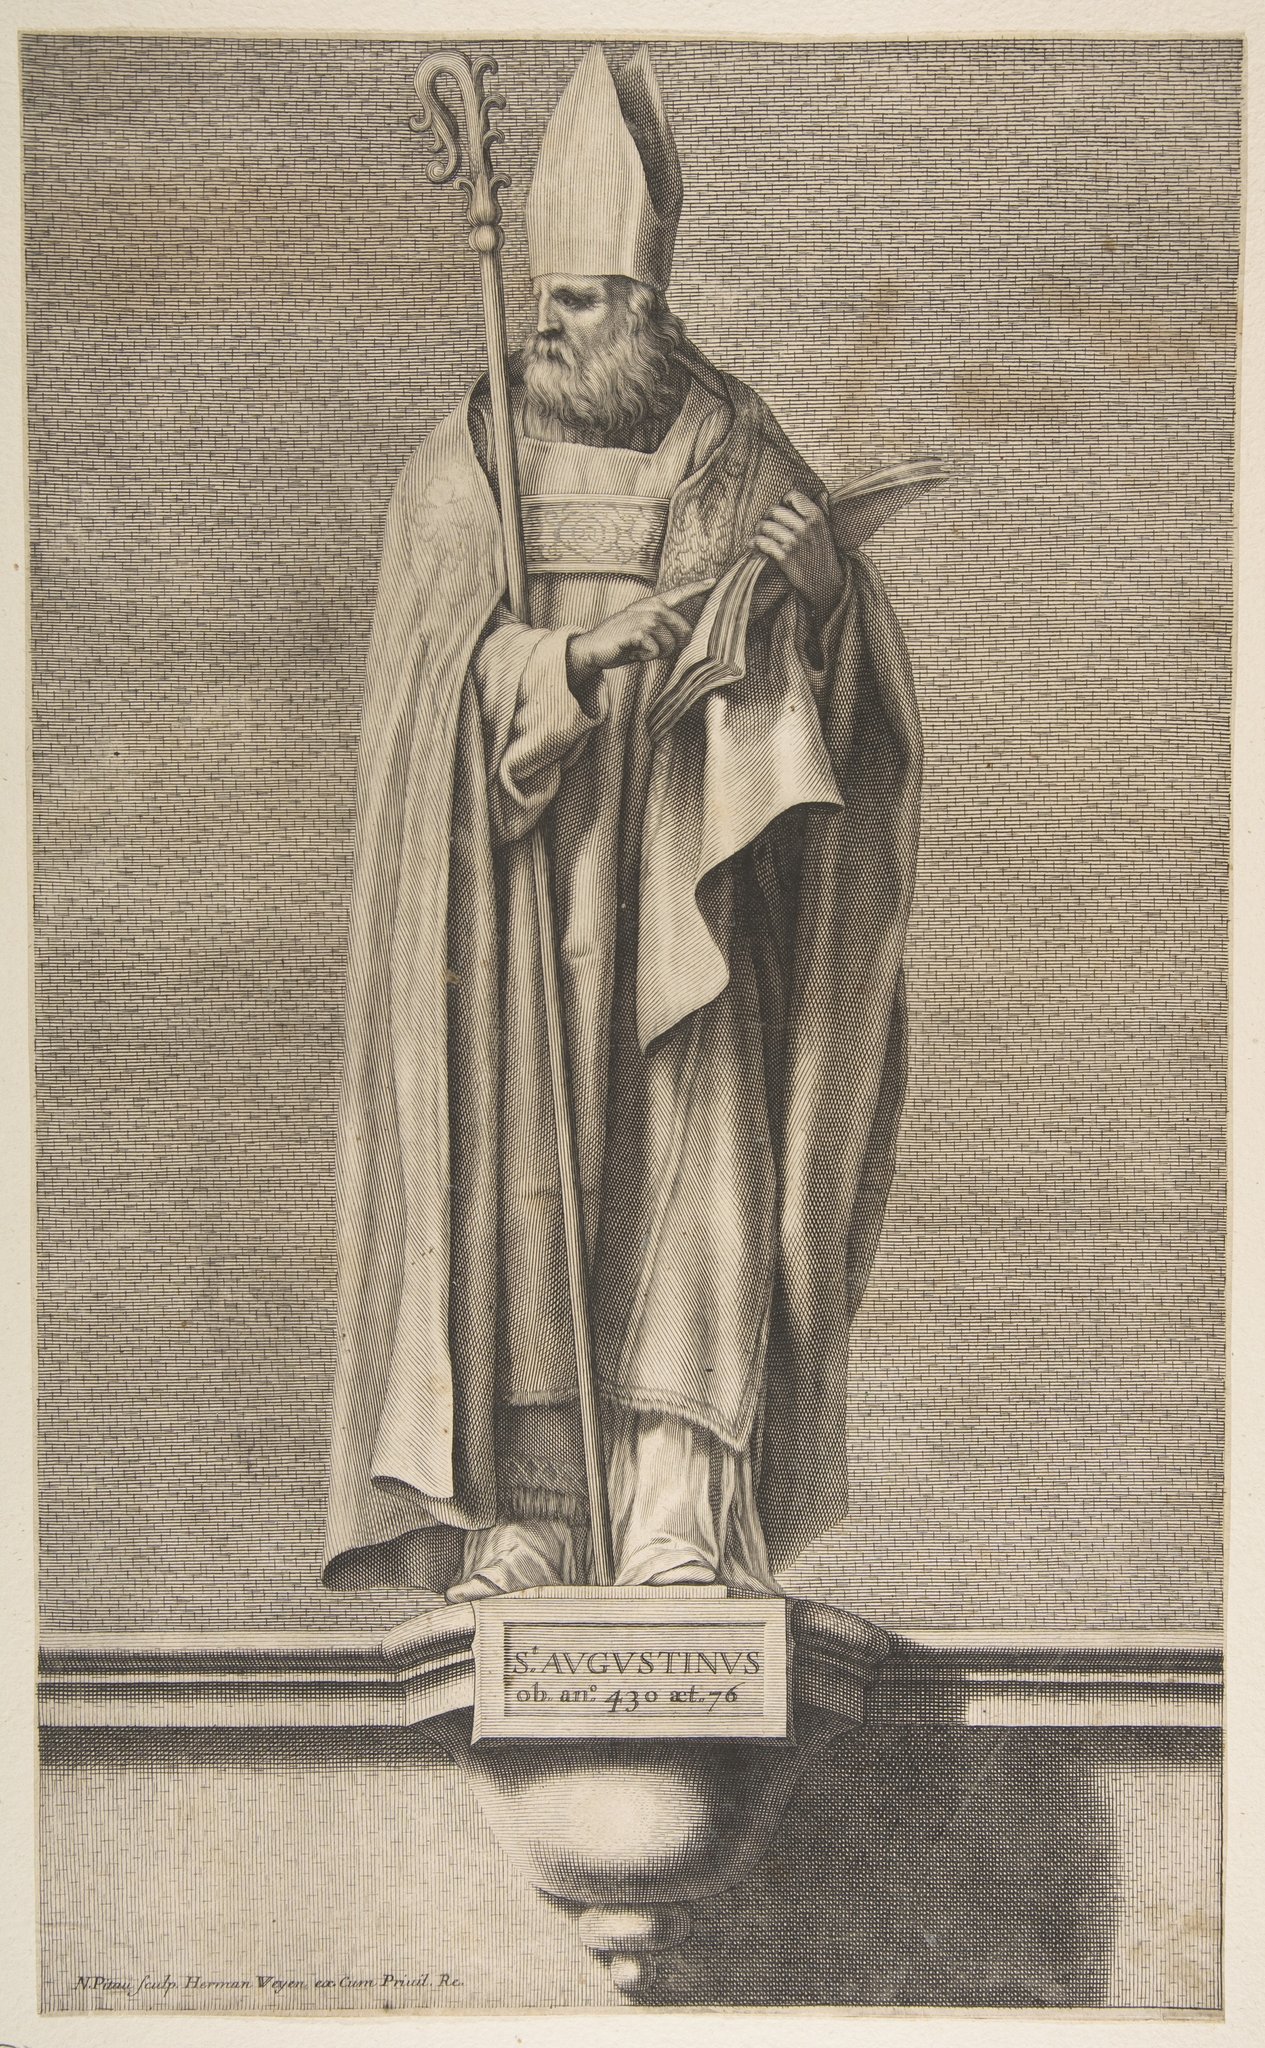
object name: print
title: St. Augustine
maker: nicolas pitau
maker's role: artist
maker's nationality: french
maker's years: 1670-1724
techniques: engraving, etching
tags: men,saints